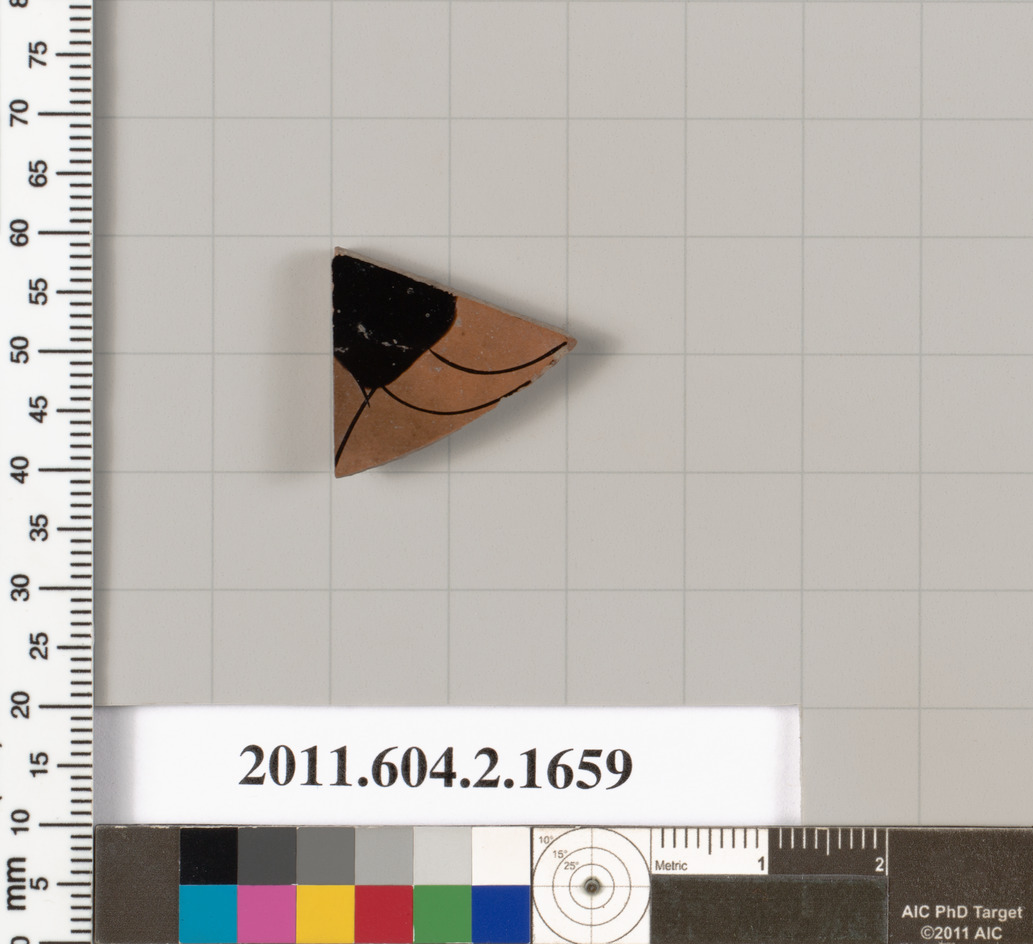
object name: skyphos fragment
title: Terracotta fragment of a skyphos (deep drinking cup)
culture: greek, attic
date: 460-440 BCE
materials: terracotta